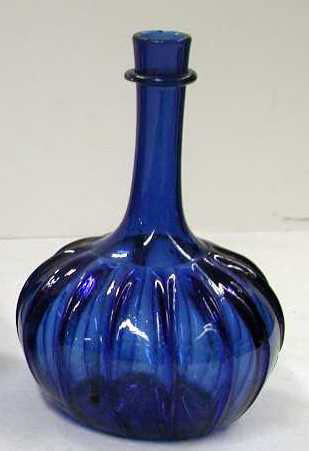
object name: bottle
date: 1601-1700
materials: glass